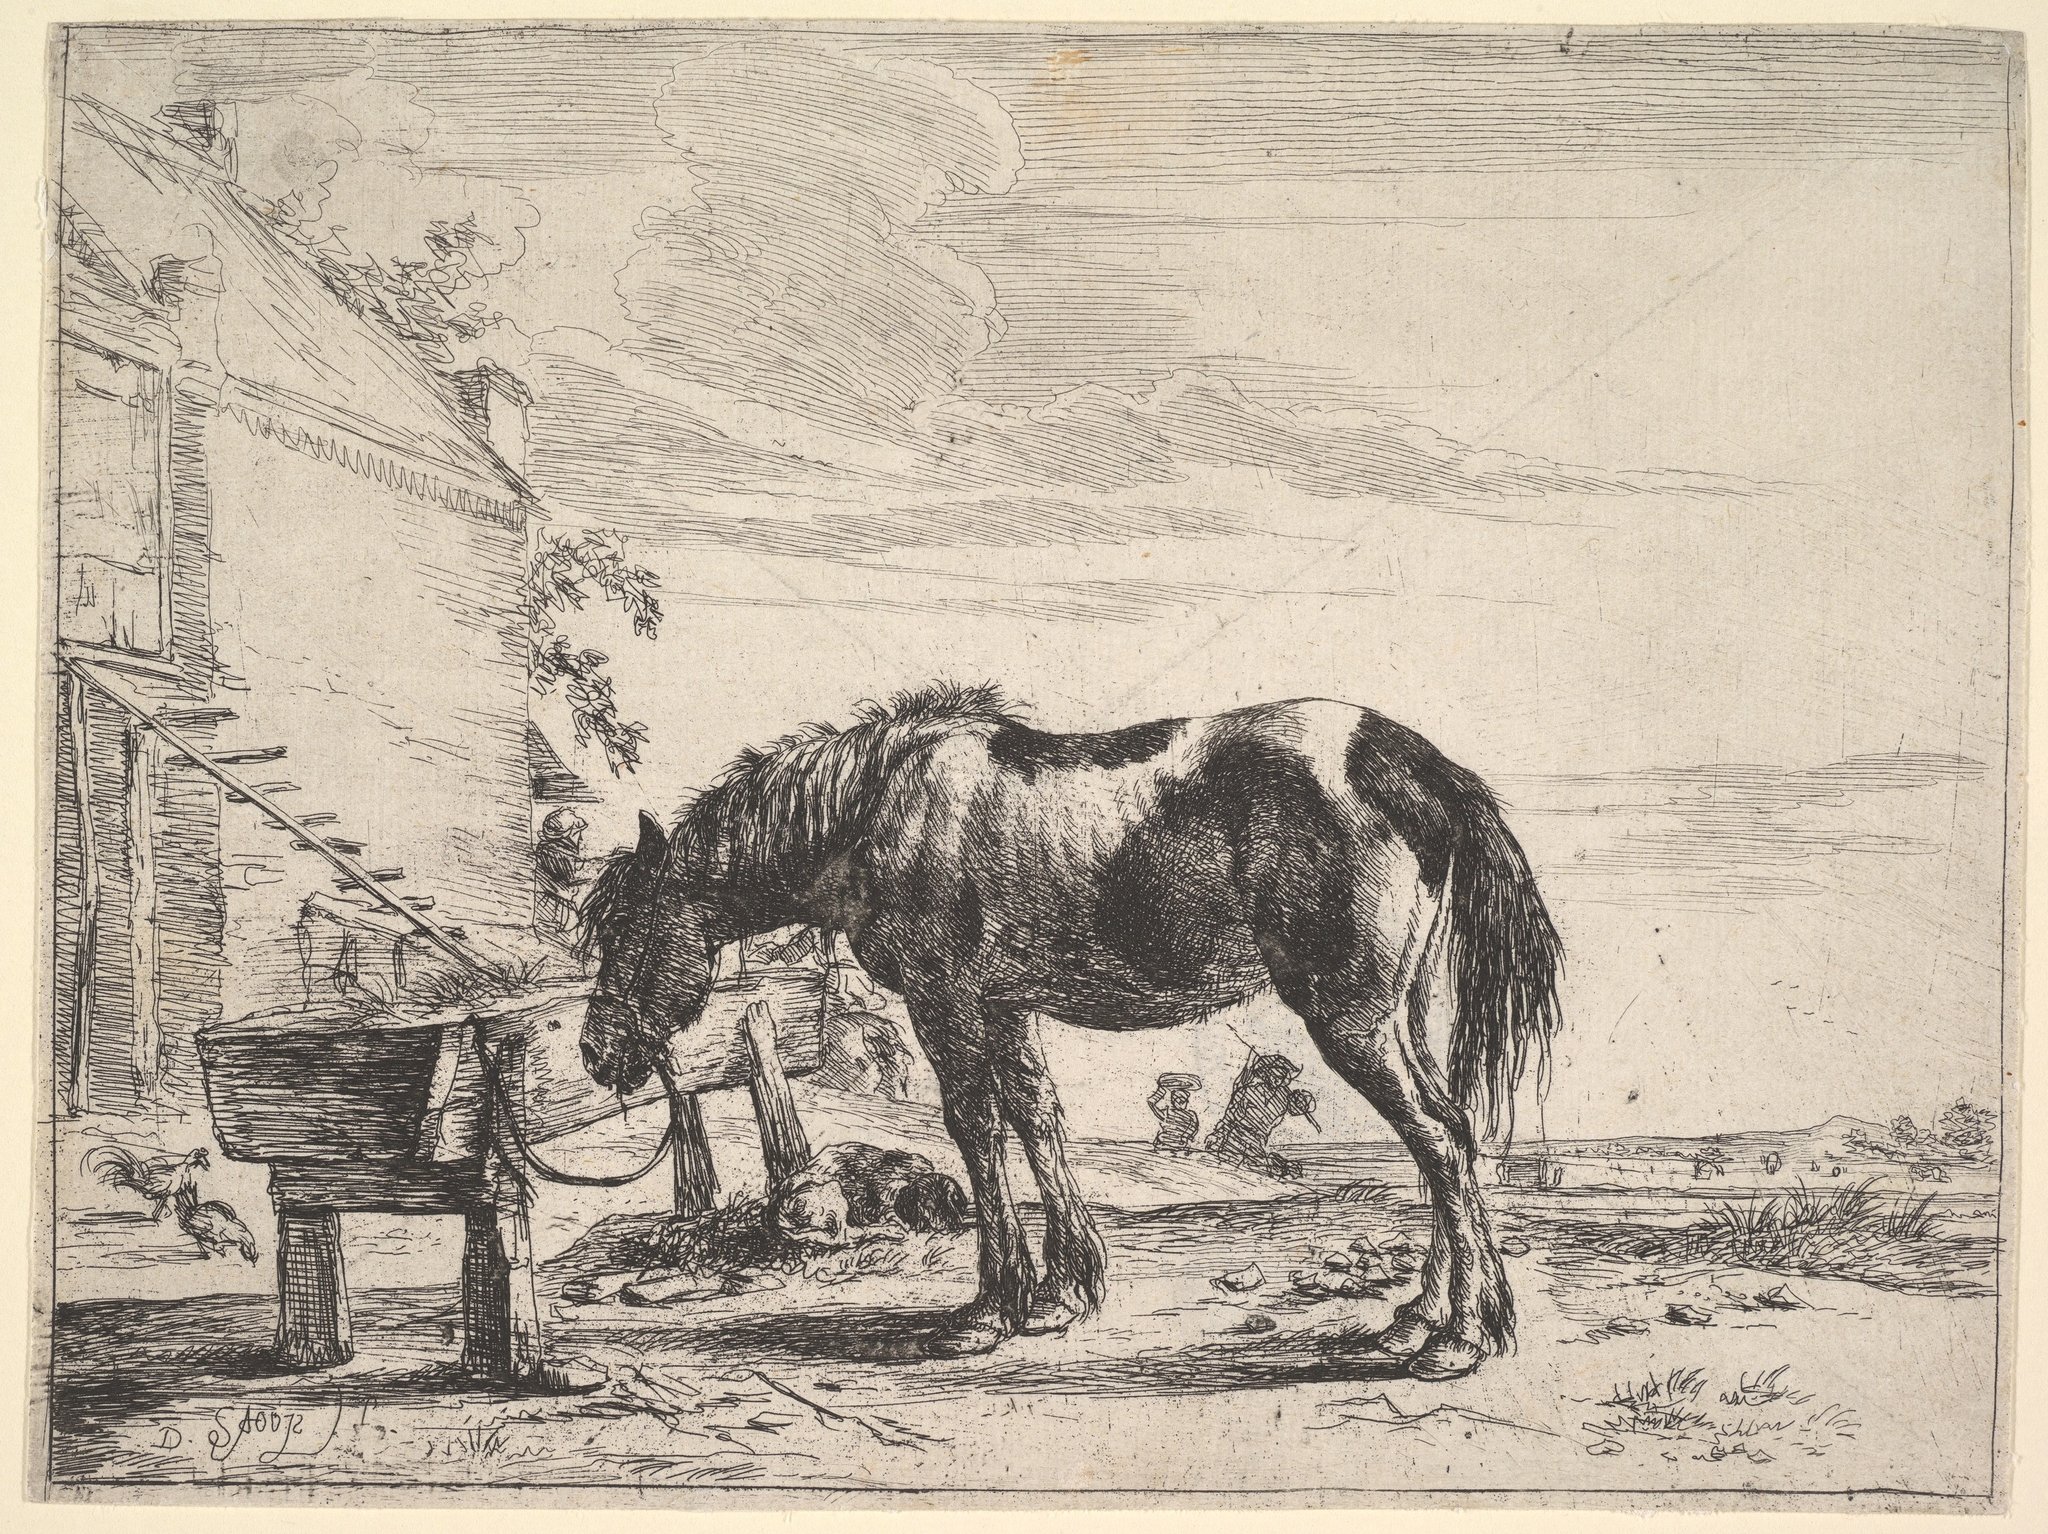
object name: print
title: Horse Bound to a Feeding Trough, from "The Horses"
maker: dirck stoop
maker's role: artist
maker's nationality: dutch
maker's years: 1610-1686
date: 1610-1686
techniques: etching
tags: horses